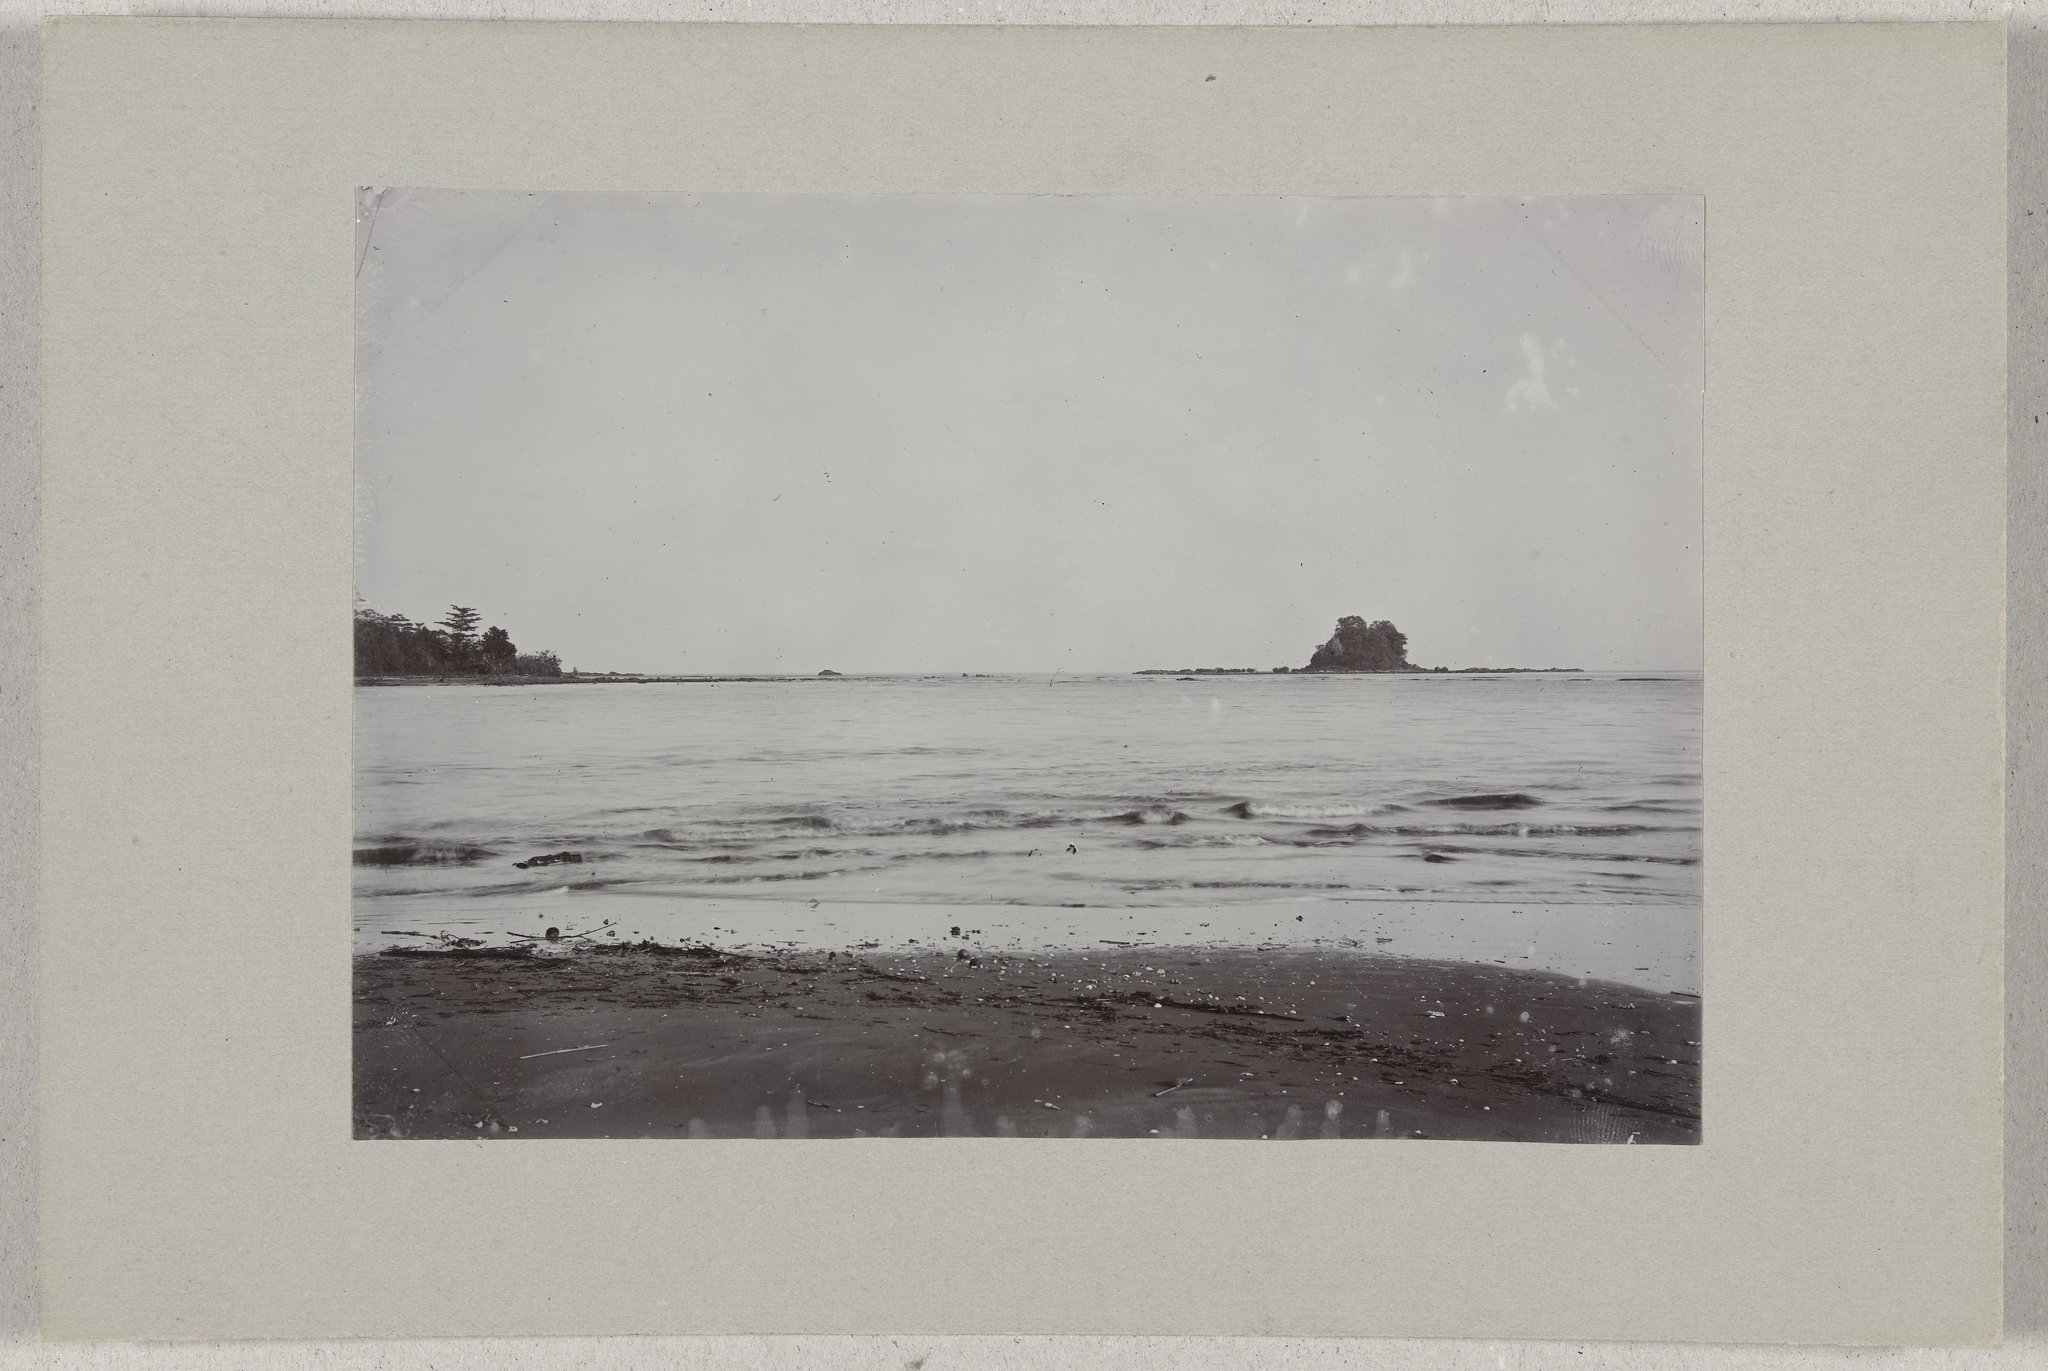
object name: photograph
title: 58a Wijnkoopsbaai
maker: Anonymous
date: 1895-1915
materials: cardboard, paper, photographic support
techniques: gelatin silver print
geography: dutch east indies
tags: indonesia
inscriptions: annotation: ‘58a Wijnkoopsbaai’